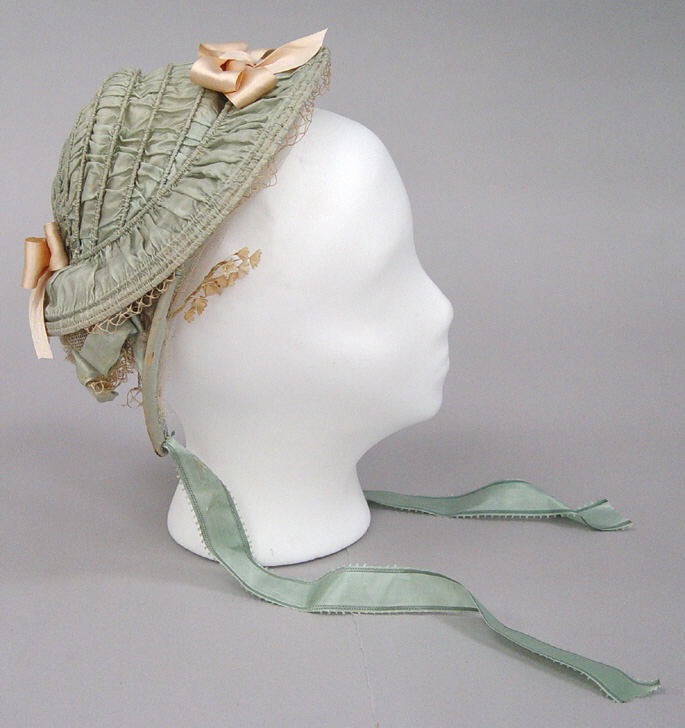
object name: bonnet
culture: american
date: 1853-1857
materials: silk